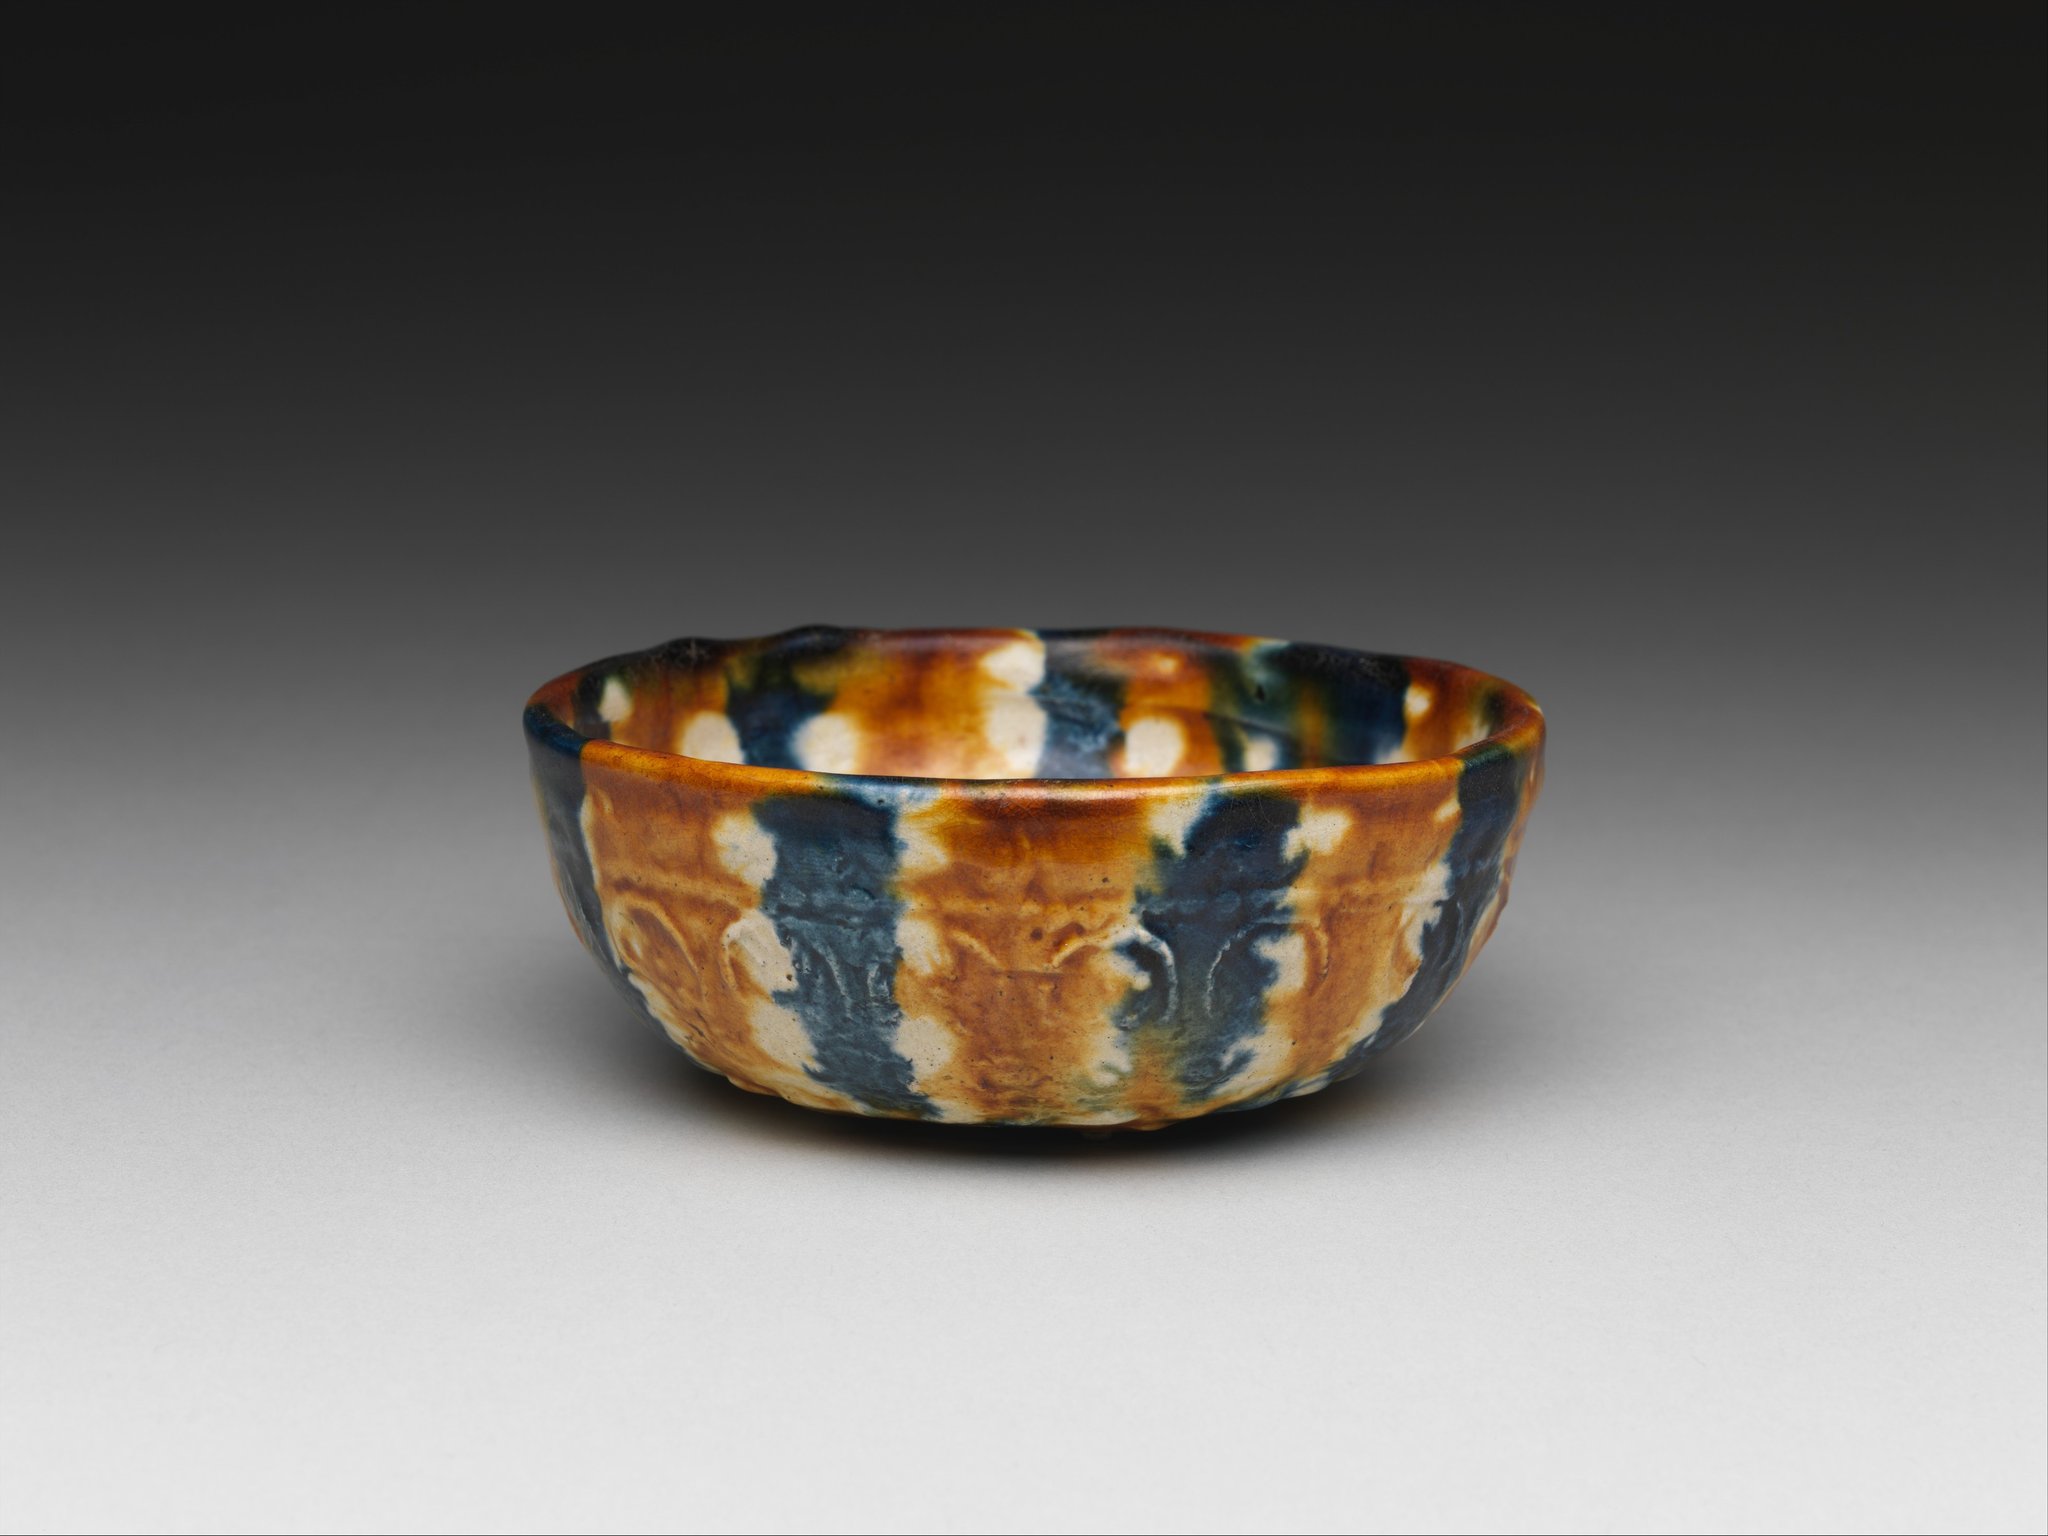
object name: bowl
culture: chinese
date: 701-800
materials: earthenware, glaze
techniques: molding